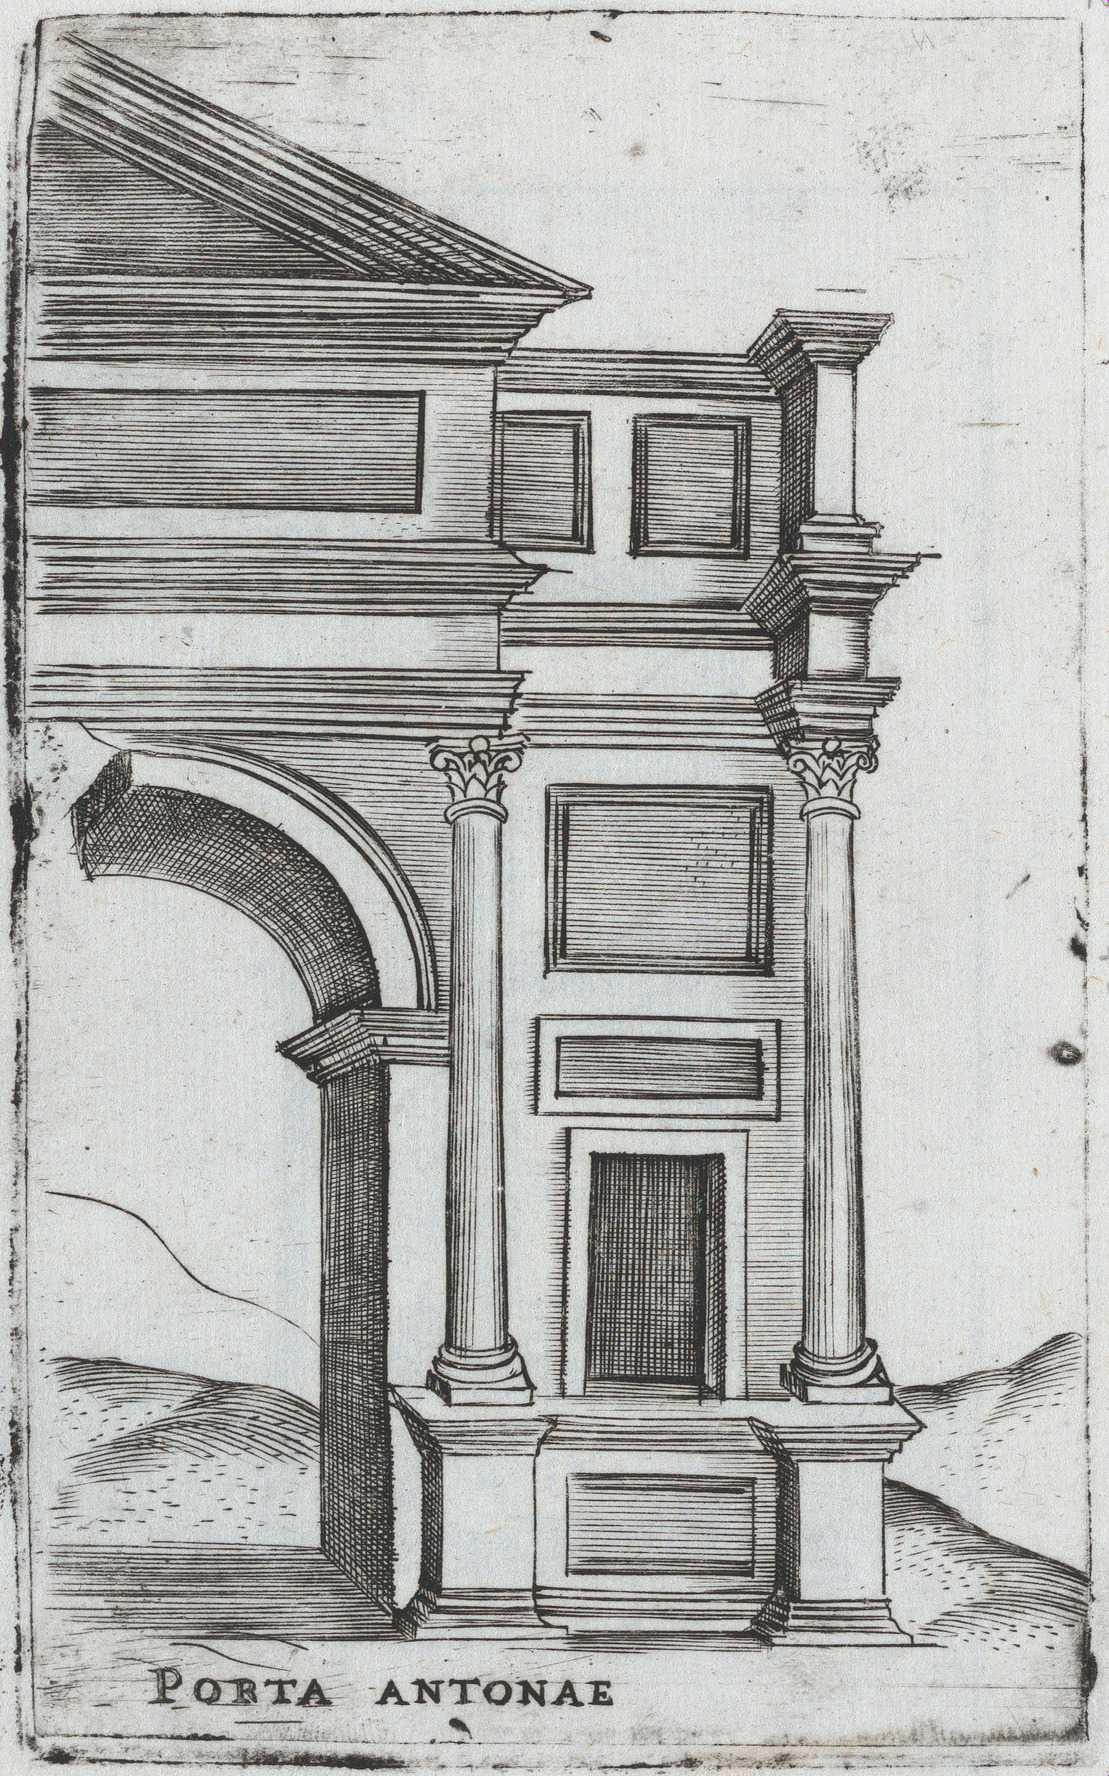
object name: album print ornament architecture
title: Palatium Maius Ro, from a Series of Prints depicting (reconstructed) Buildings from Roman Antiquity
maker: monogrammist g.a. with the caltrop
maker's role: artist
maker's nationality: italian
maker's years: 1535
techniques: engraving, printing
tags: architecture,arches